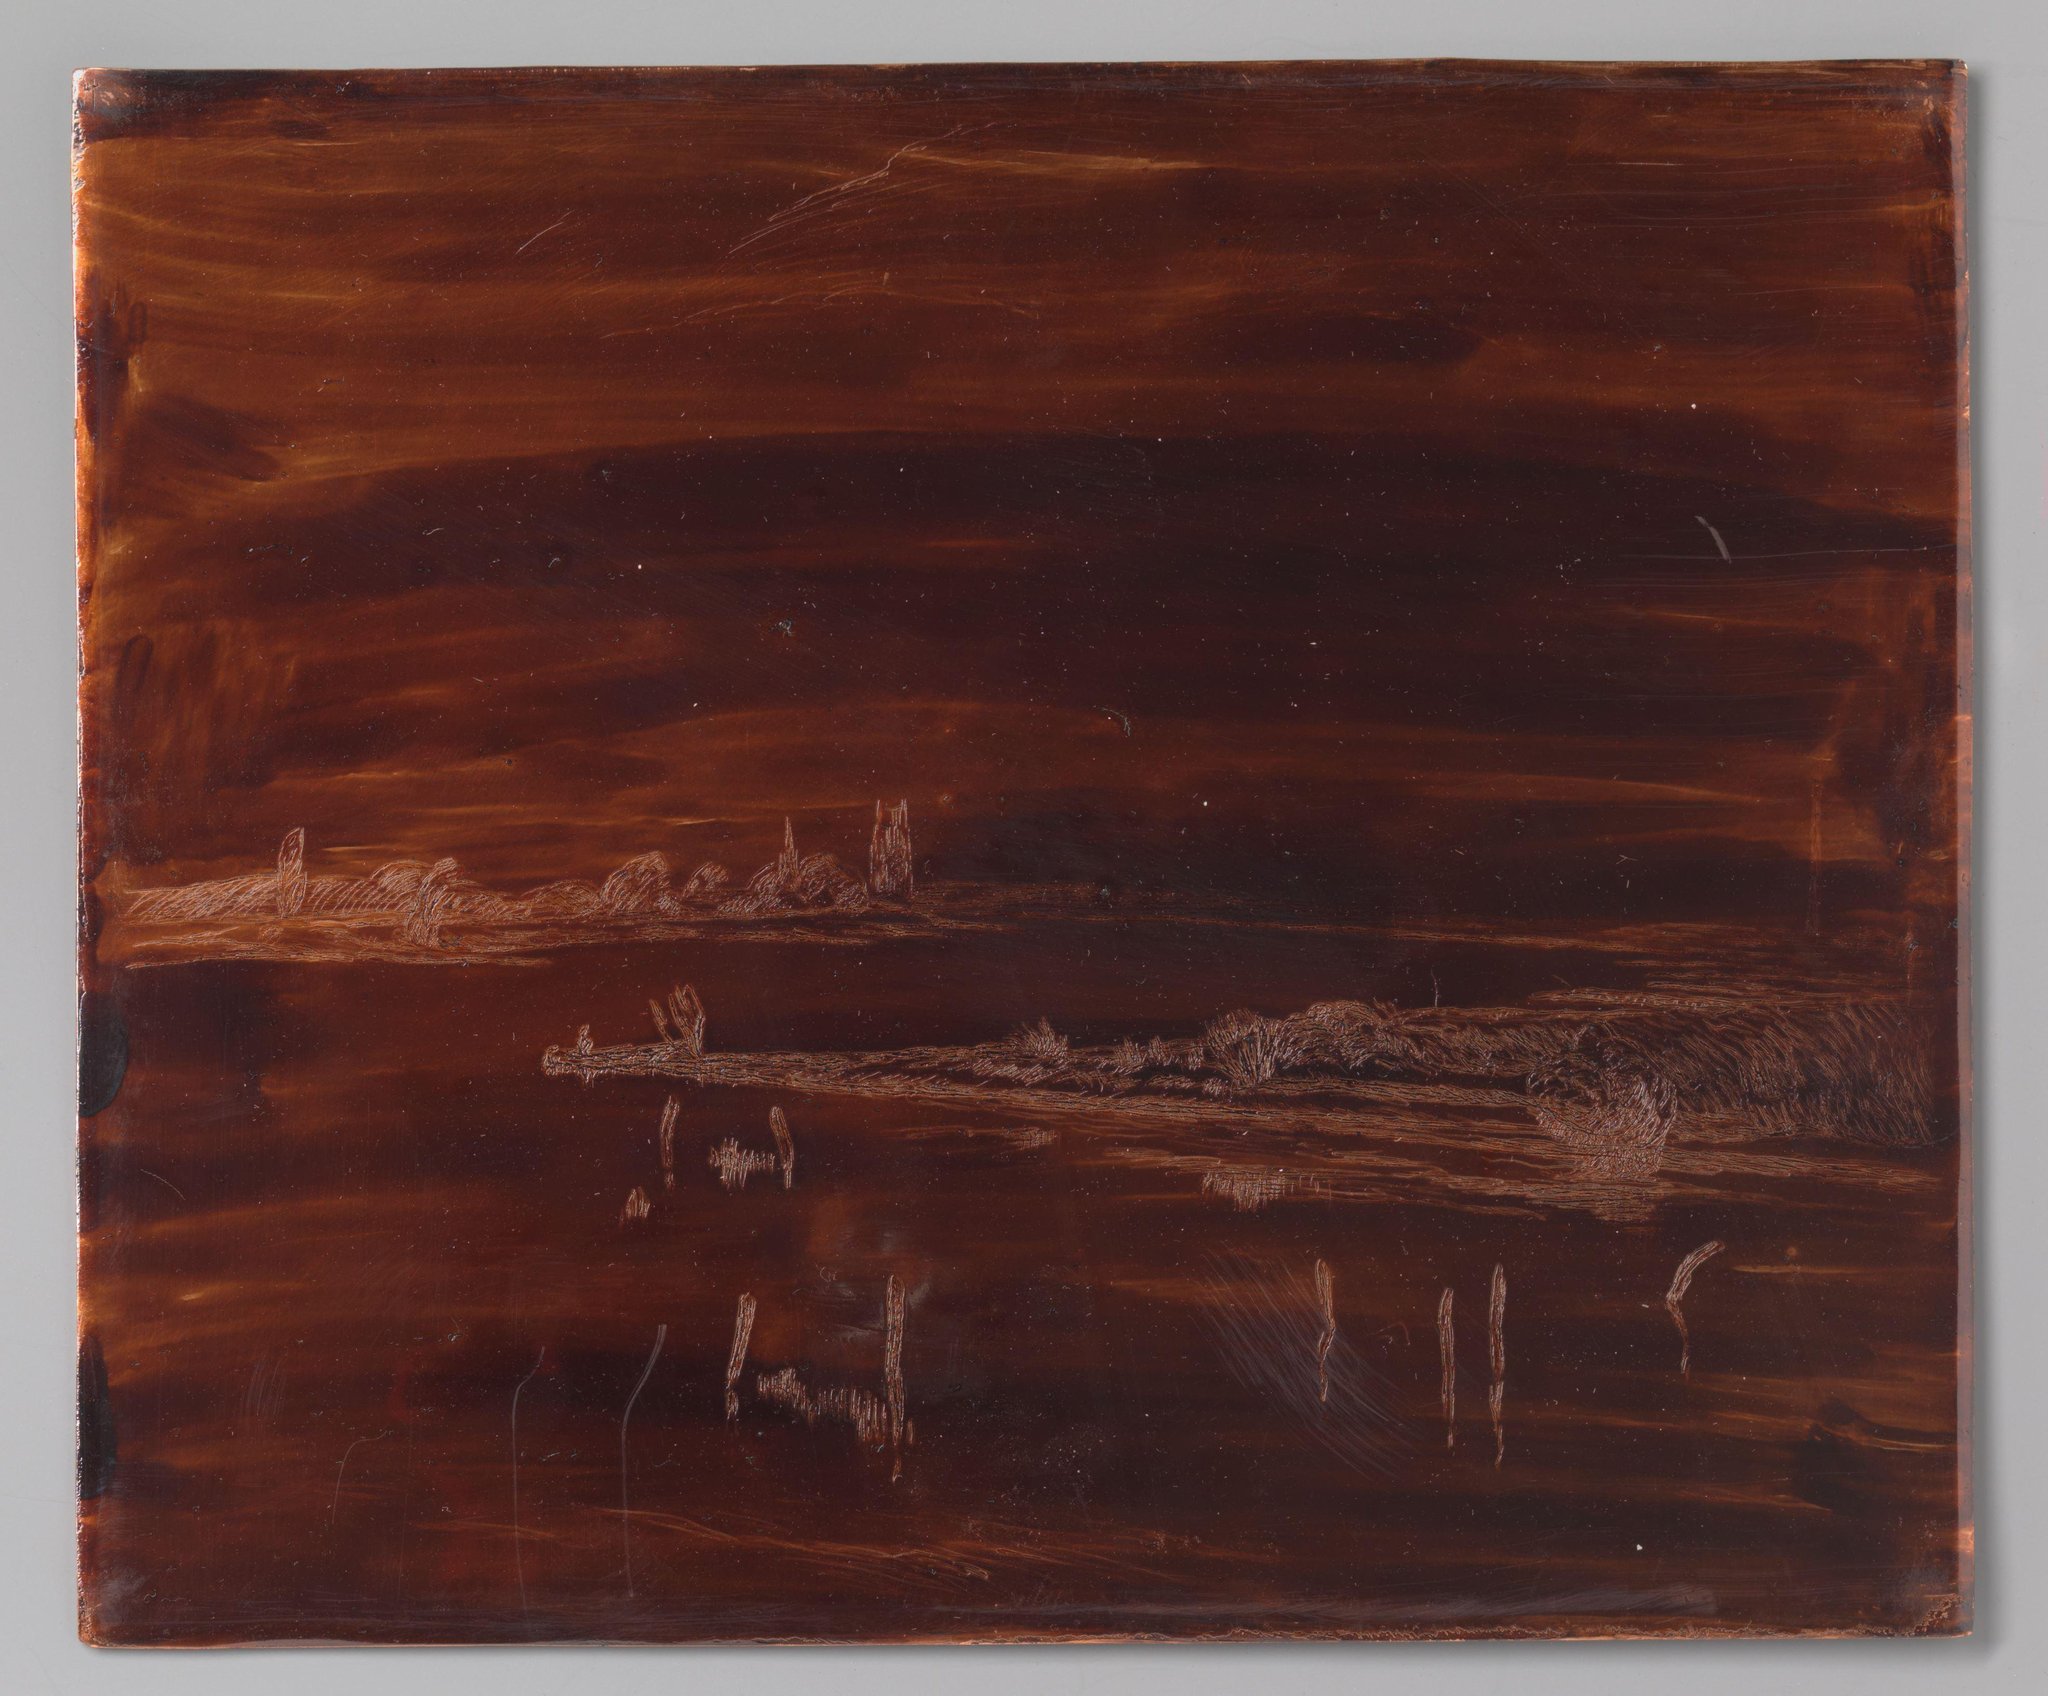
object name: copper plate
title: Rivierlandschap met toren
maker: antoon derkzen van angeren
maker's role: draughtsman, print maker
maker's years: 1878-1961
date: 1926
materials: copper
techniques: etching